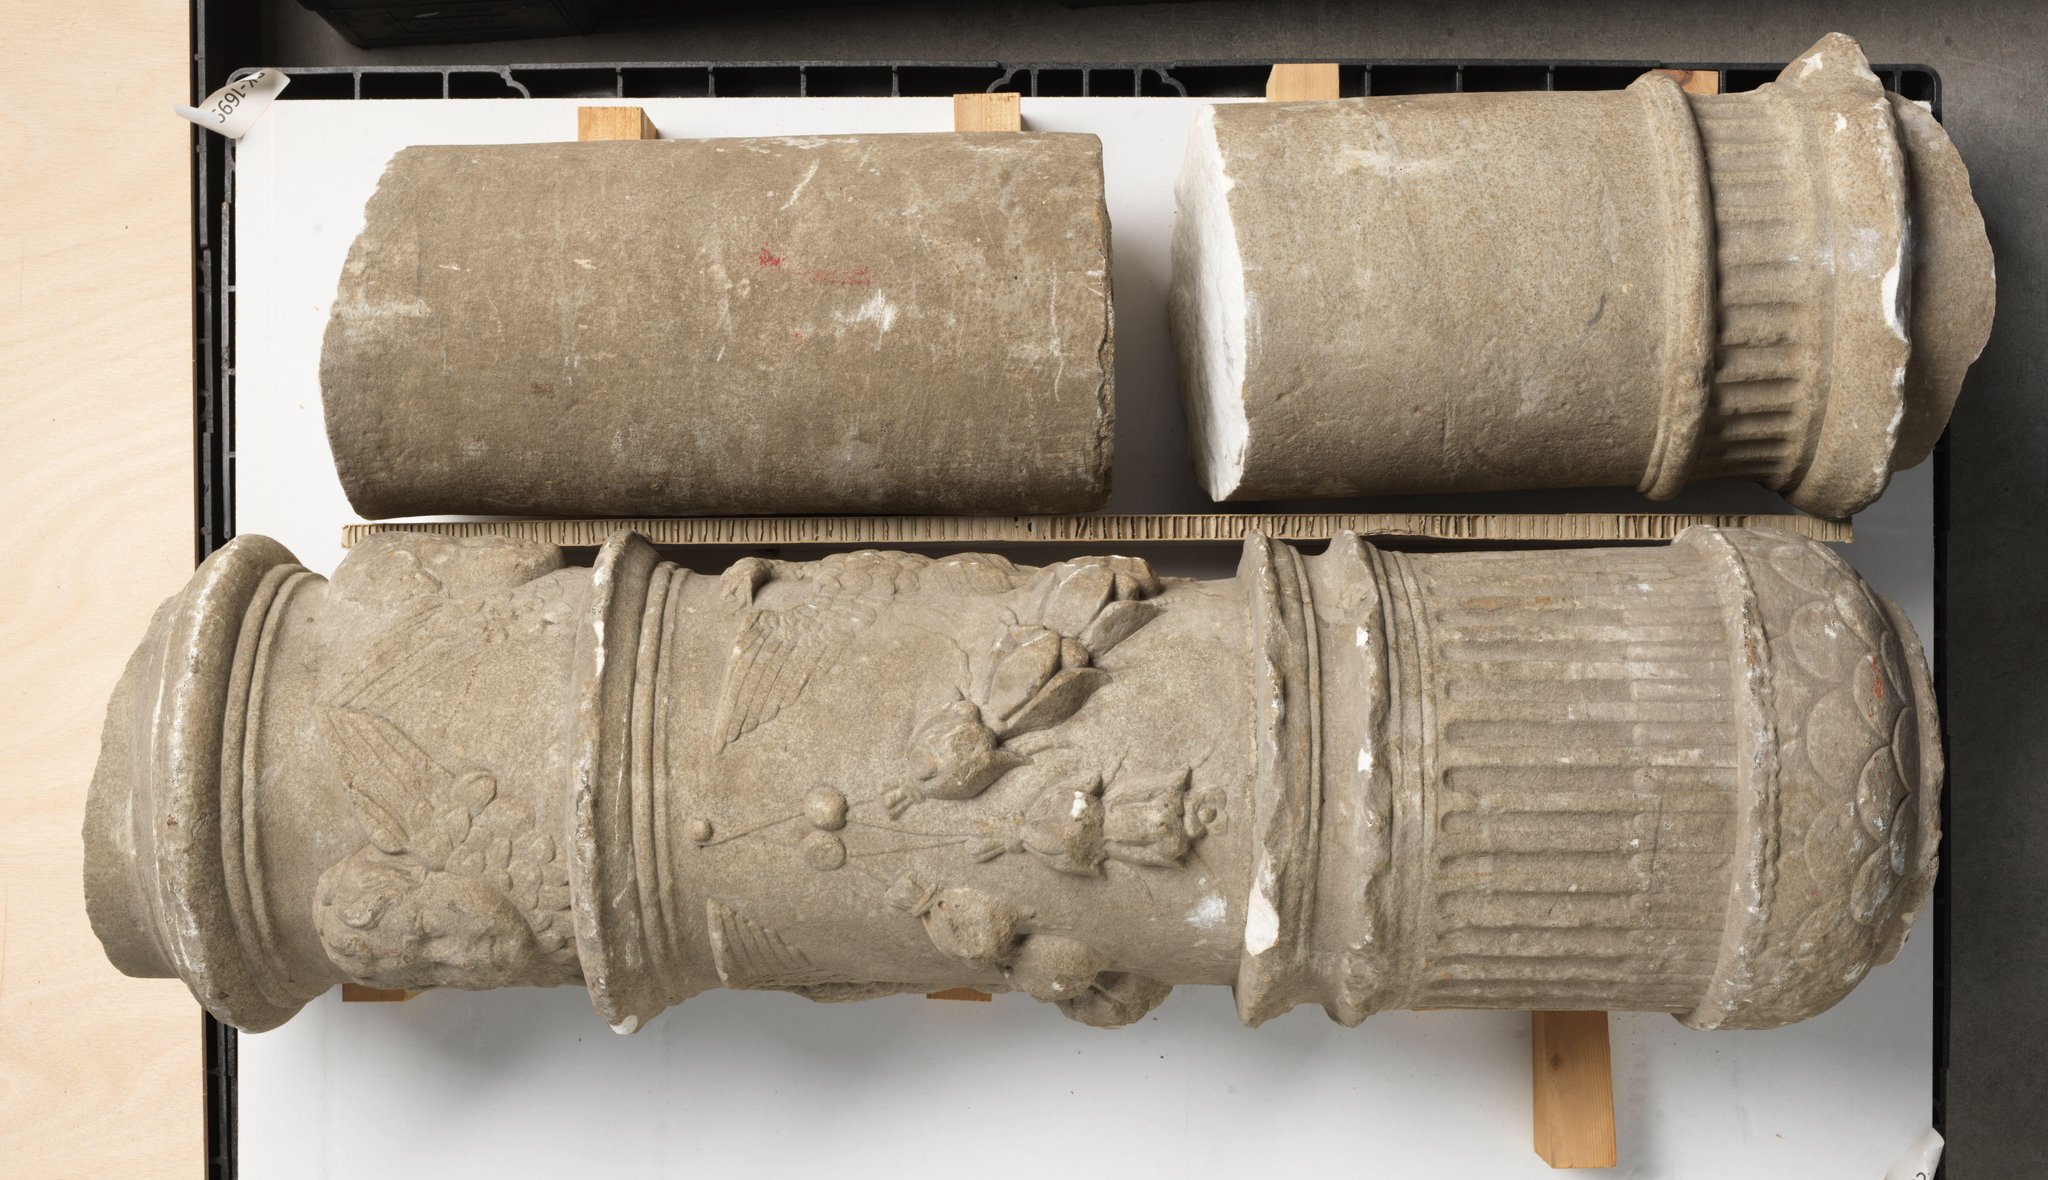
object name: column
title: Drie onderdelen van een zuil van marmer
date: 1500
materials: marble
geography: italy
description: De drie onderdelen maken deel uit van een zuil met composiet-kapiteel staande op een vierhoekige postament met plint. De zuil bestaat uit in totaal vijf stukken.